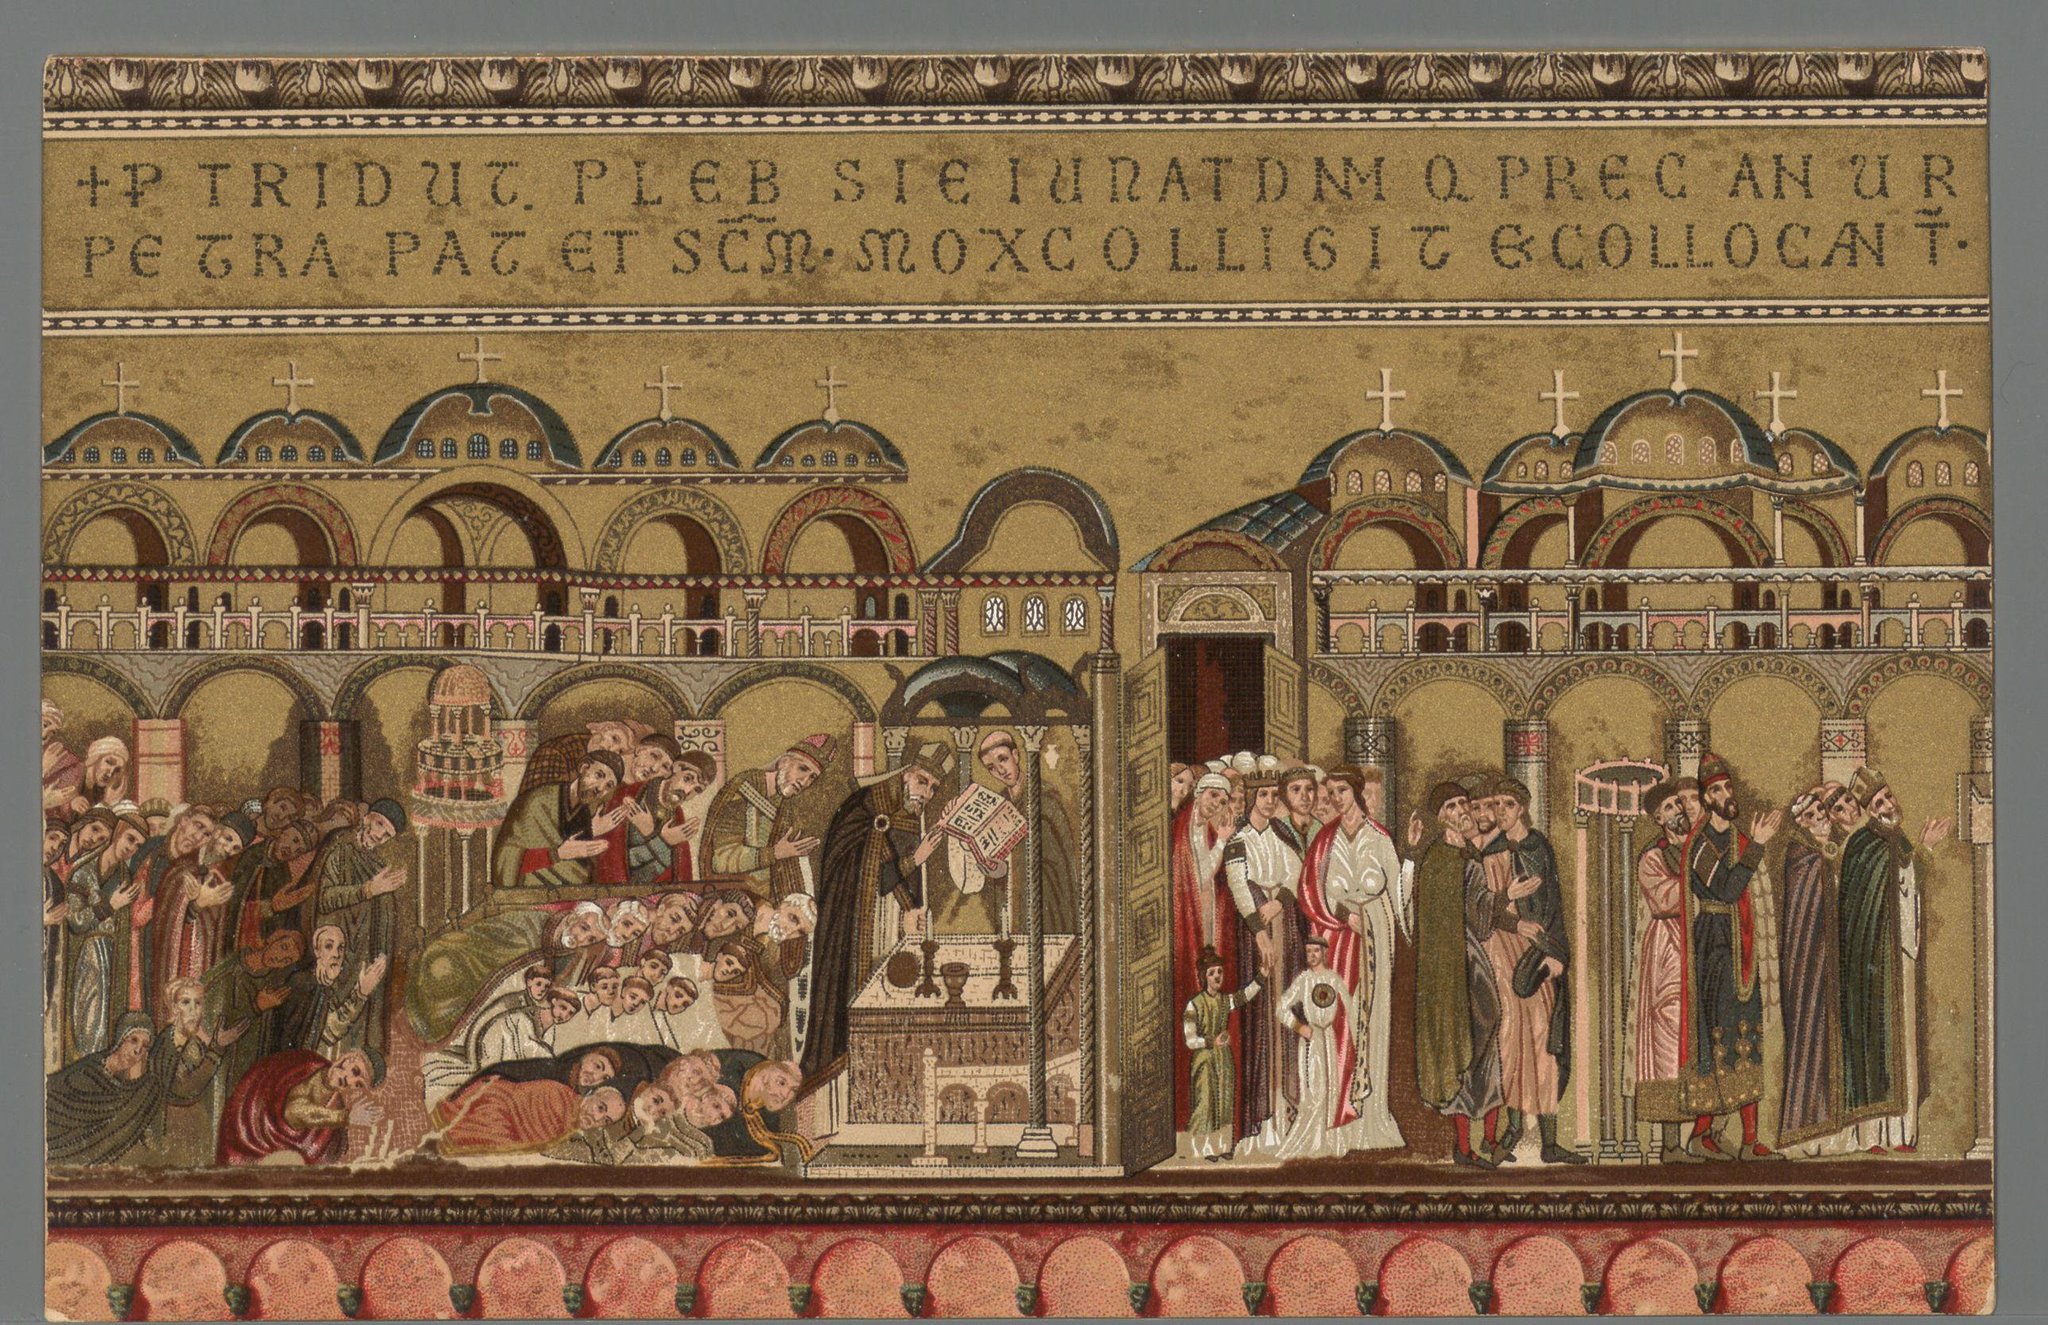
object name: print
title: Basilica di S. Marco in Venezia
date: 1906-1920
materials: cardboard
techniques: lithograph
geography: milan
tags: the monumental arts, interior of church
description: Oorspronkelijke prent uit: La Basilica di San Marco in Venezia. Venetië: Ferdinando Ongania, 1881-1884. De oorspronkelijke prenten uit dit werk zijn gesigneerd.